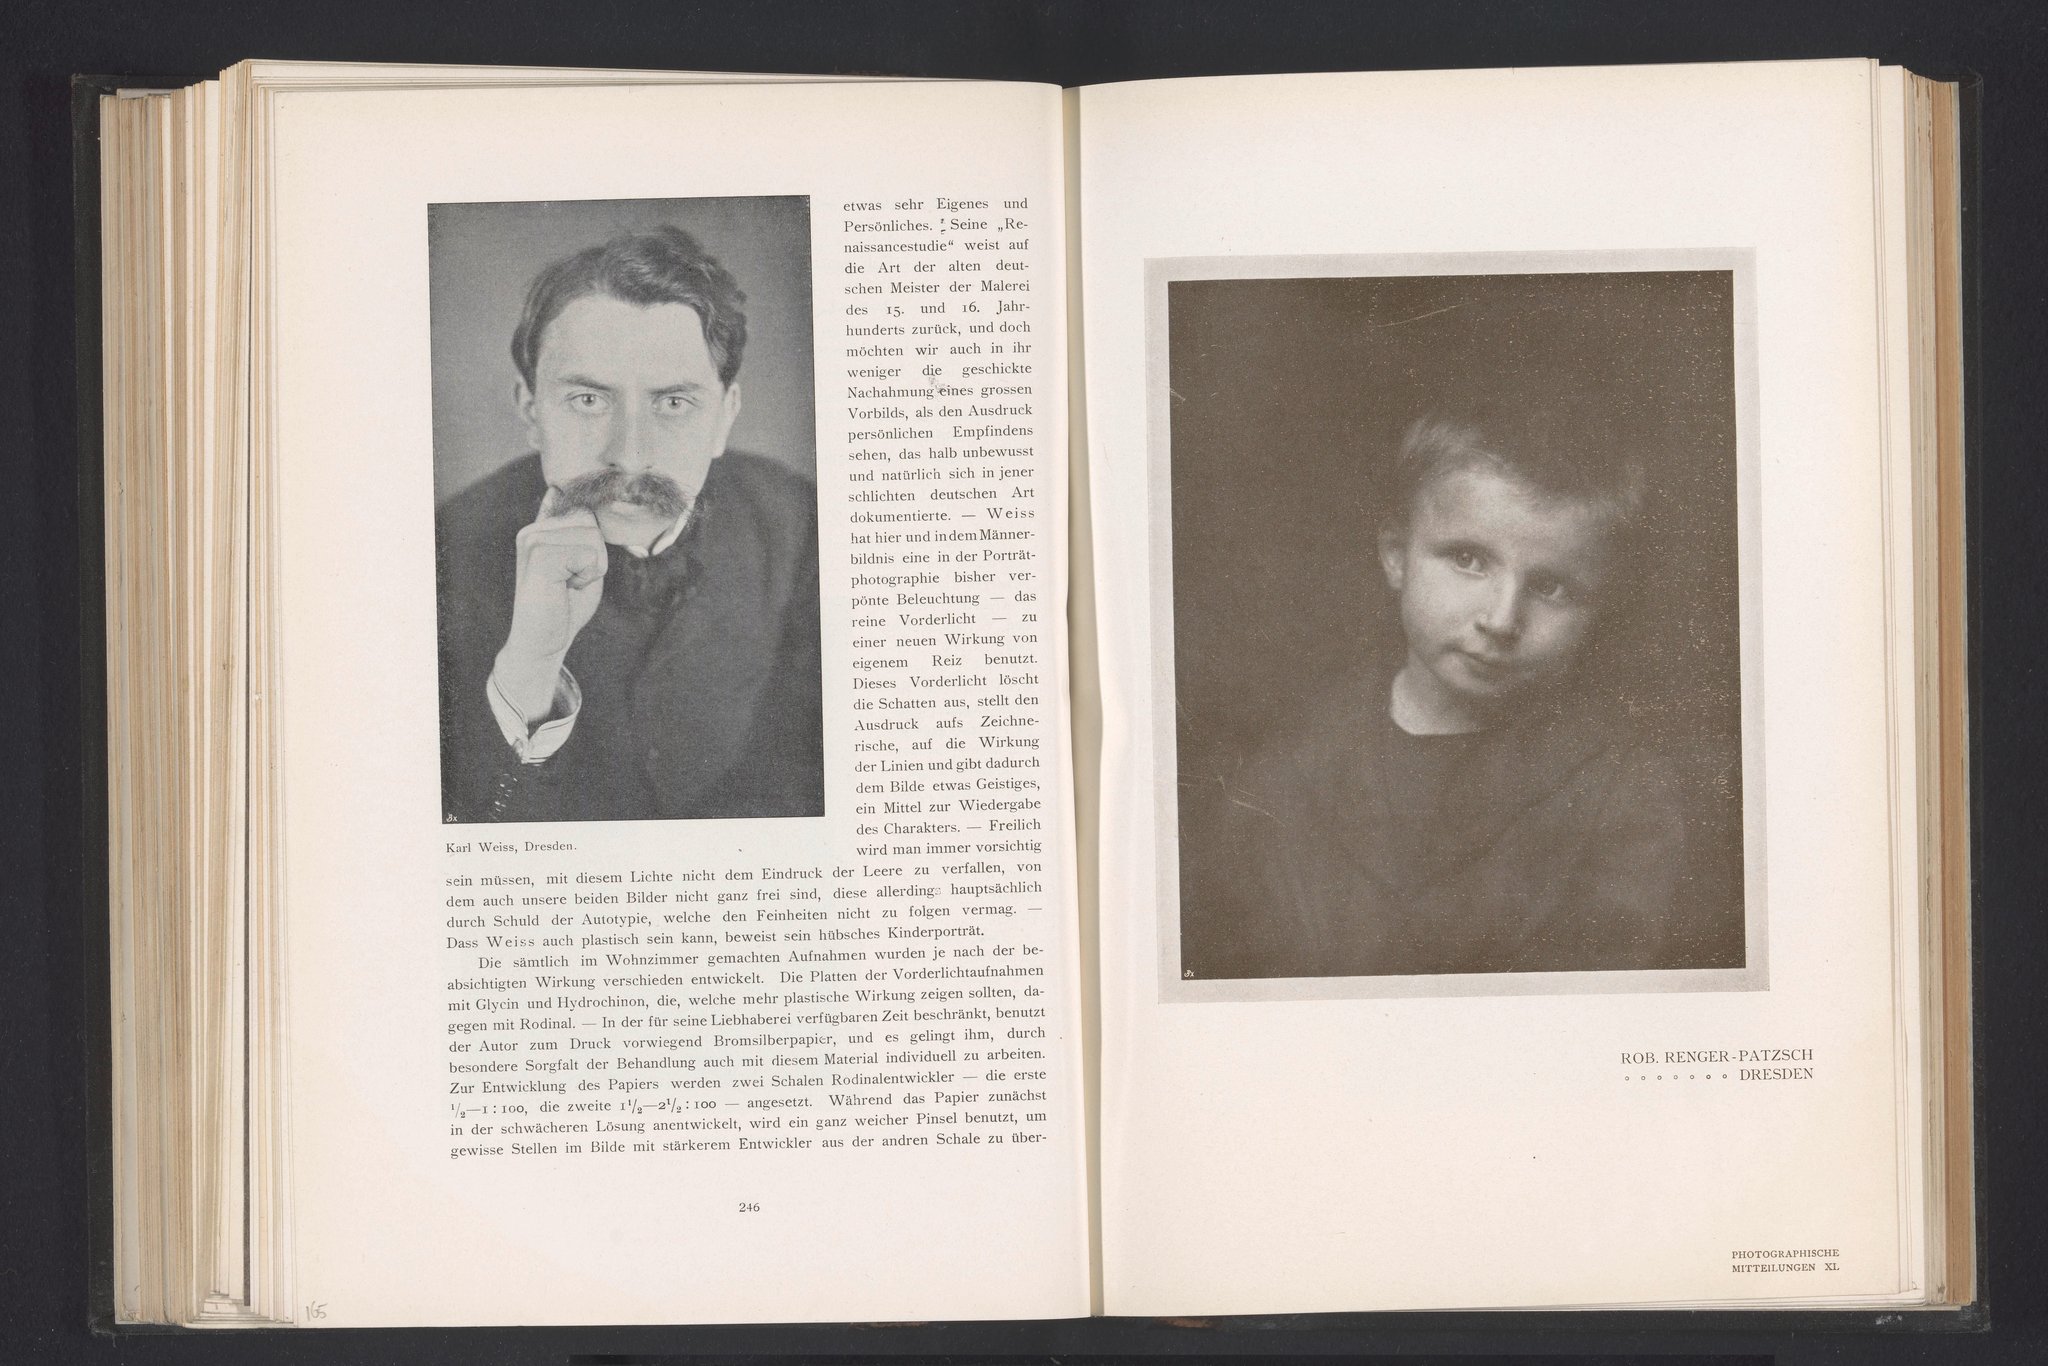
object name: page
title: Portret van een onbekende man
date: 1898-1903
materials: paper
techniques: autotype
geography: dresden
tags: historical persons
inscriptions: monogram: ‘BX’